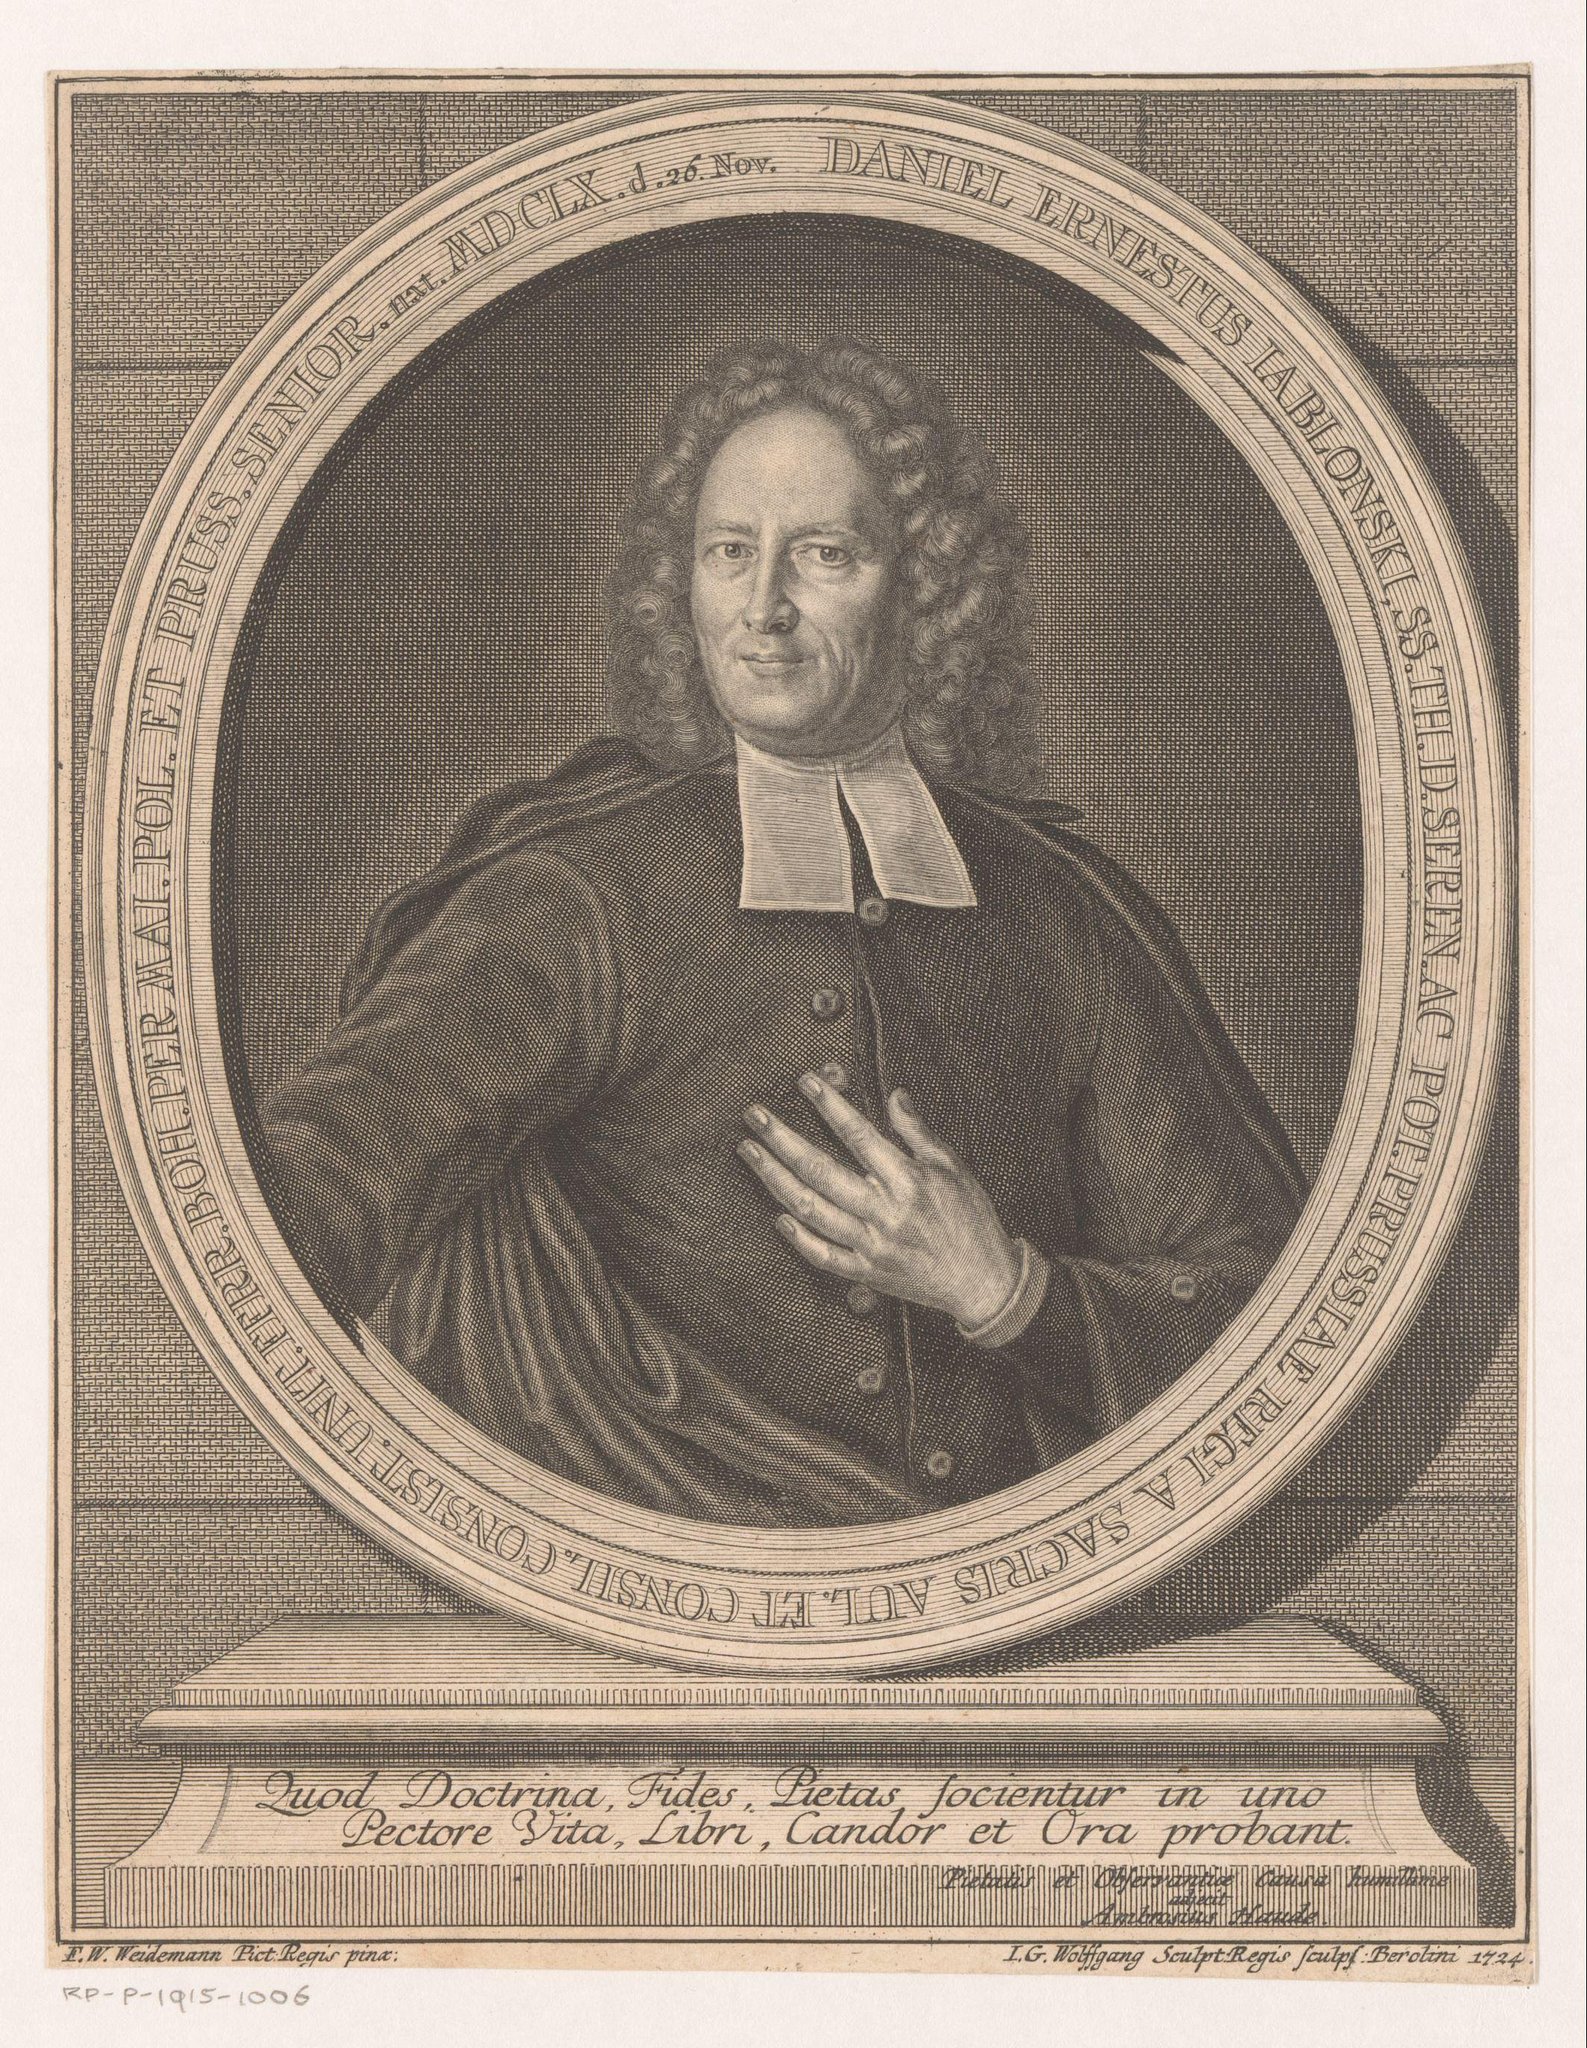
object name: print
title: Portret van Daniel Ernst Jablonski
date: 1724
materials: paper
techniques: engraving, etching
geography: berlin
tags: daniel ernst jablonski, historical persons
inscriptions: collector's mark: Lugt 2228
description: Restanten van een andere prent op verso.